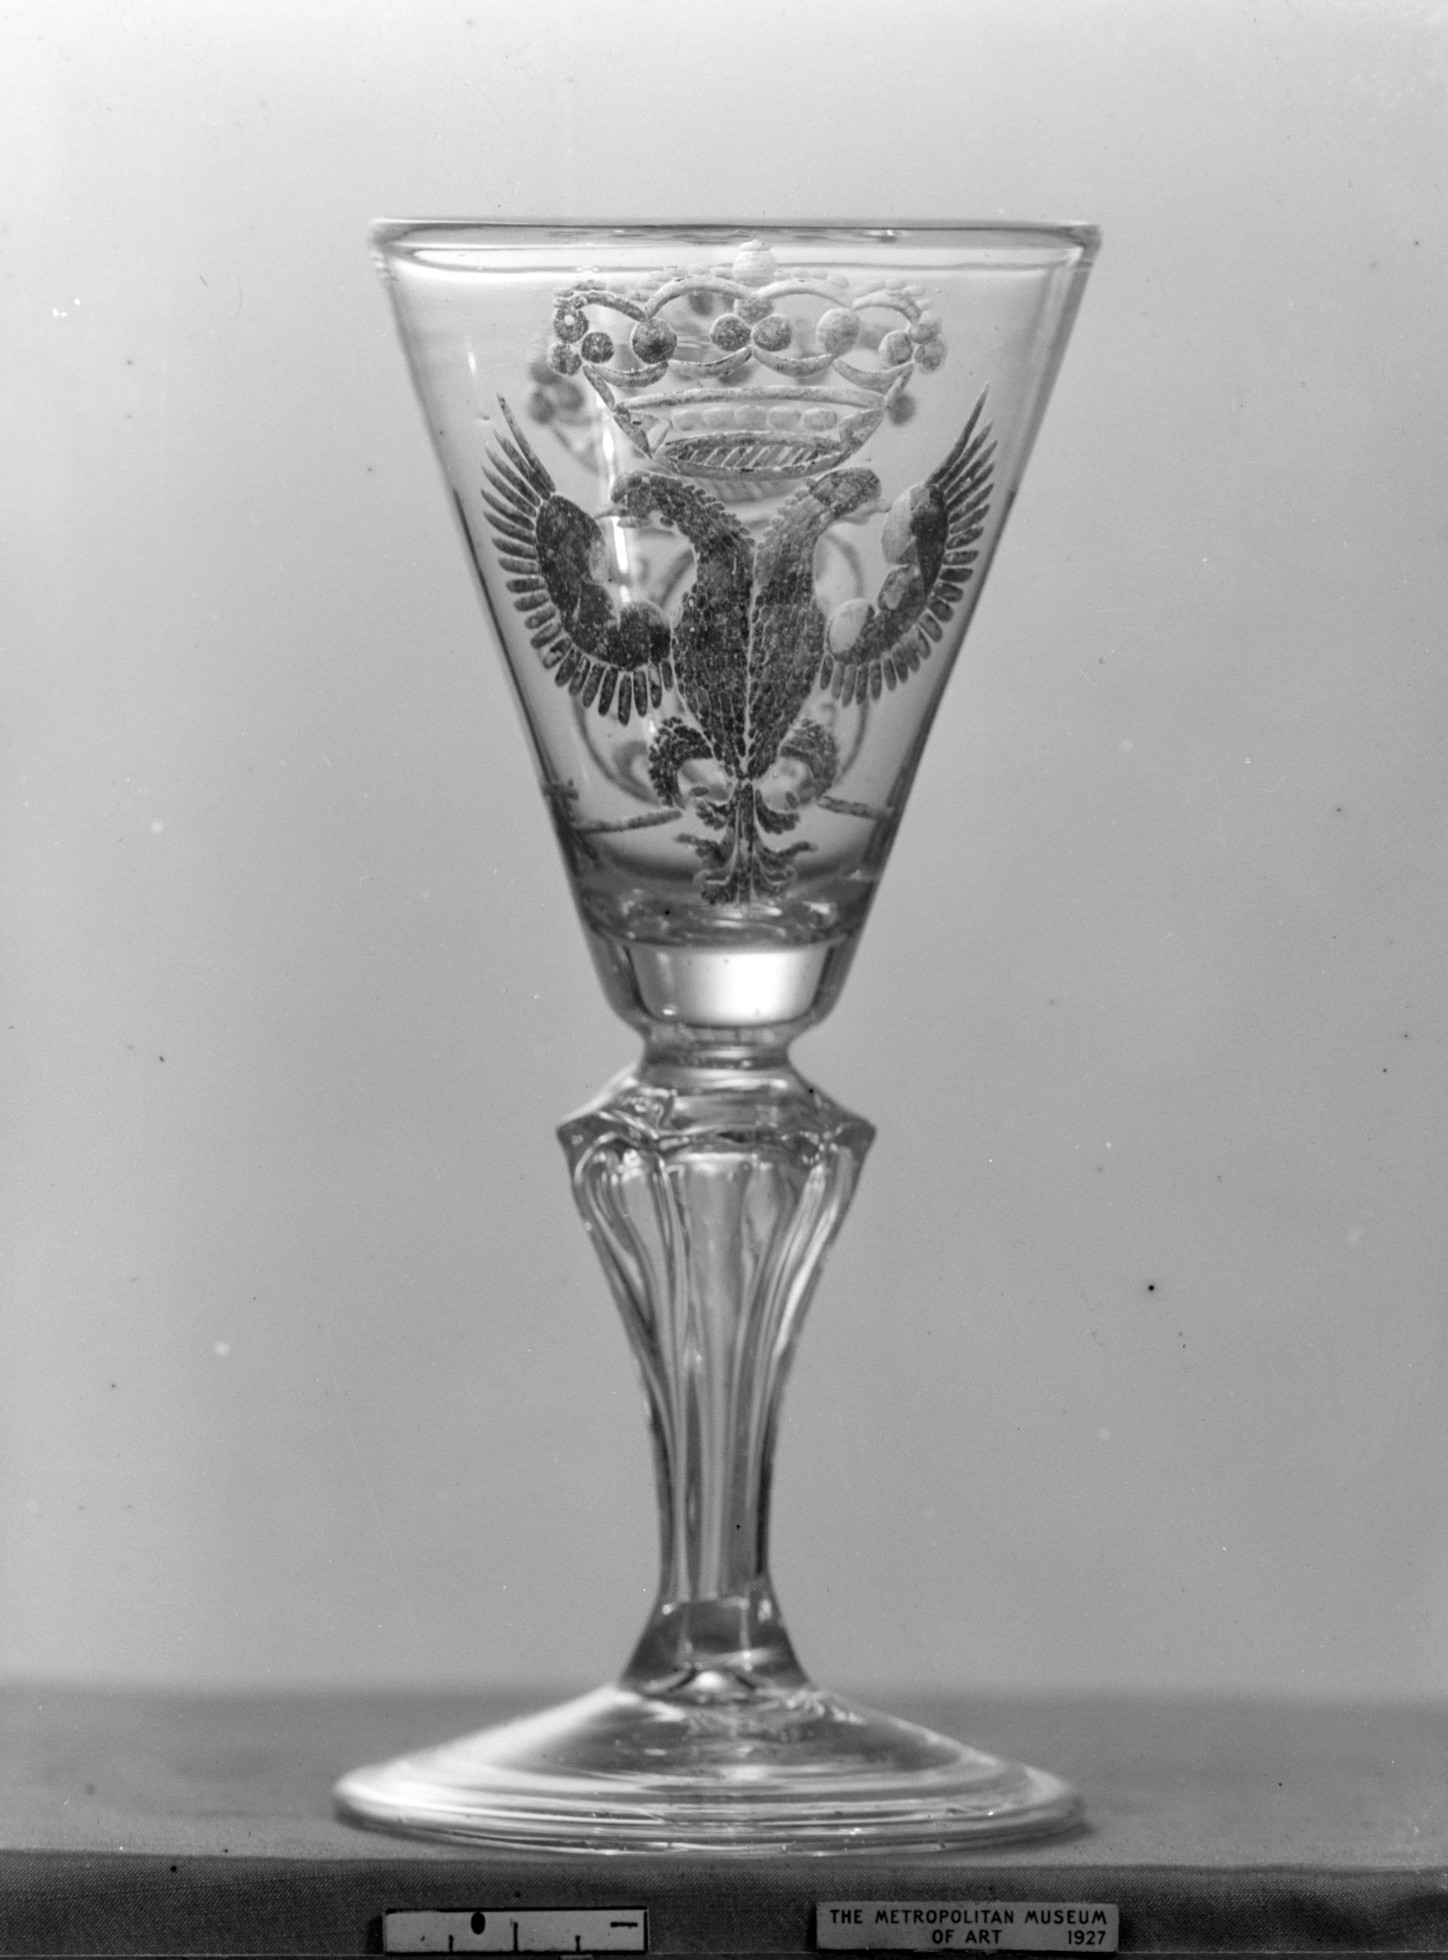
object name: wineglass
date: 1730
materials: glass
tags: coat of arms